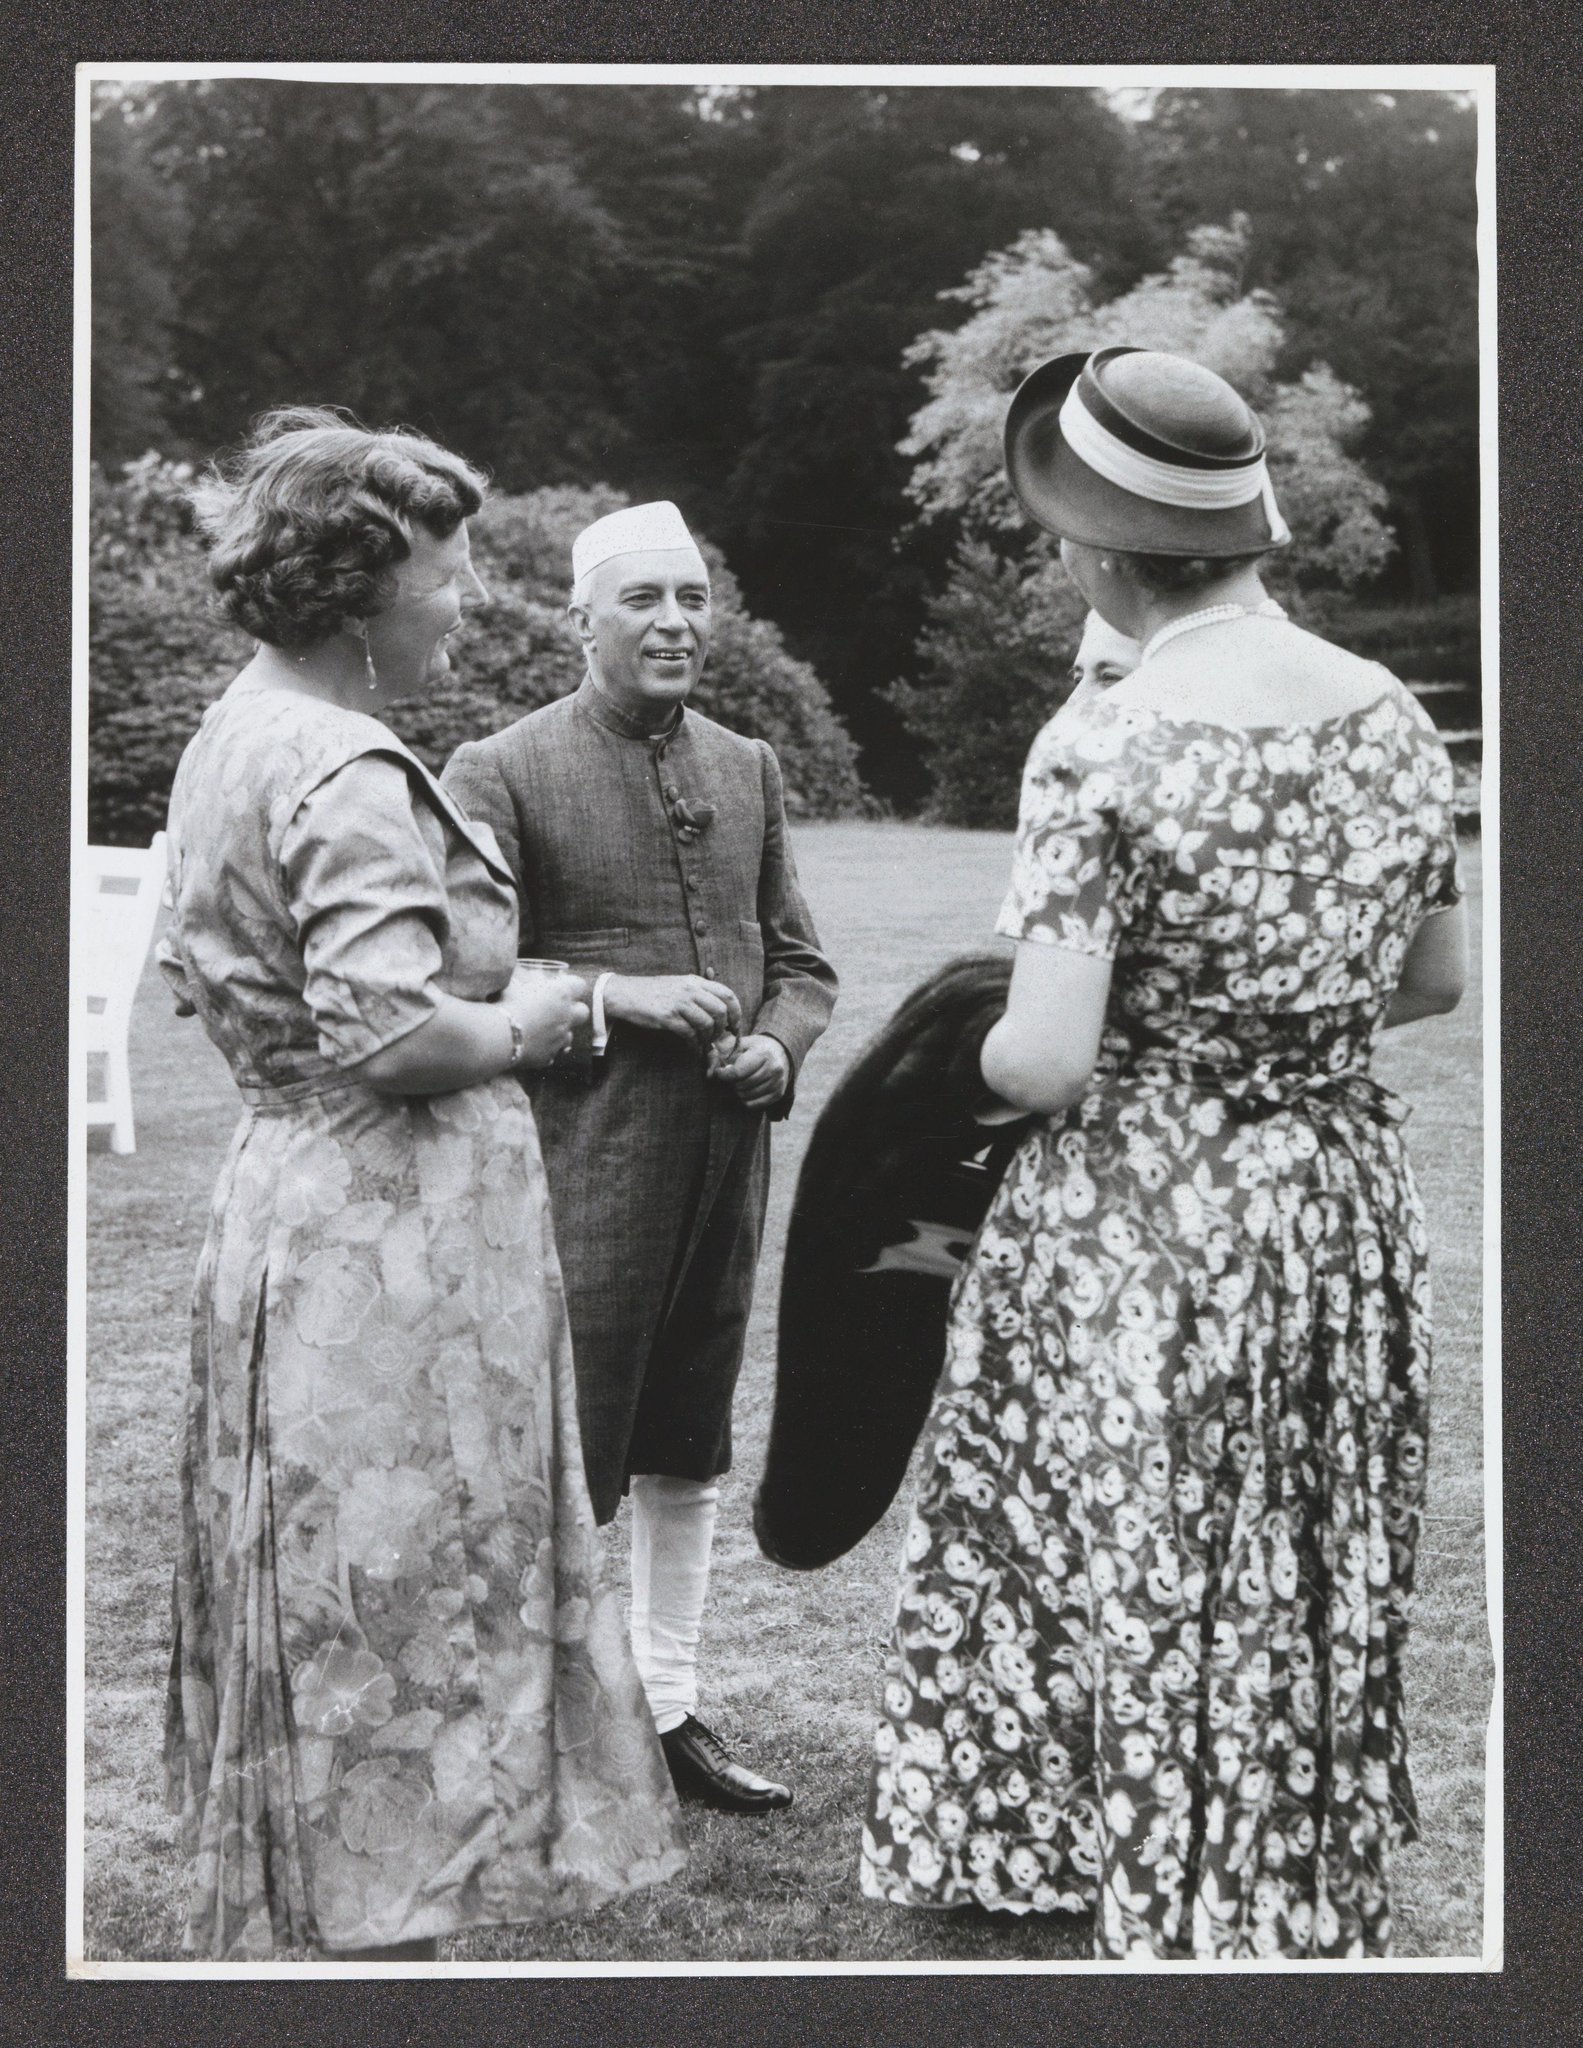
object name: photograph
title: Nehroe in Nederland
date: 1957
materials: paper, photographic support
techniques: gelatin silver print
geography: amsterdam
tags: politician, juliana of the netherlands, the hague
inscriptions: name: ‘Copyright Anefo no 87575’